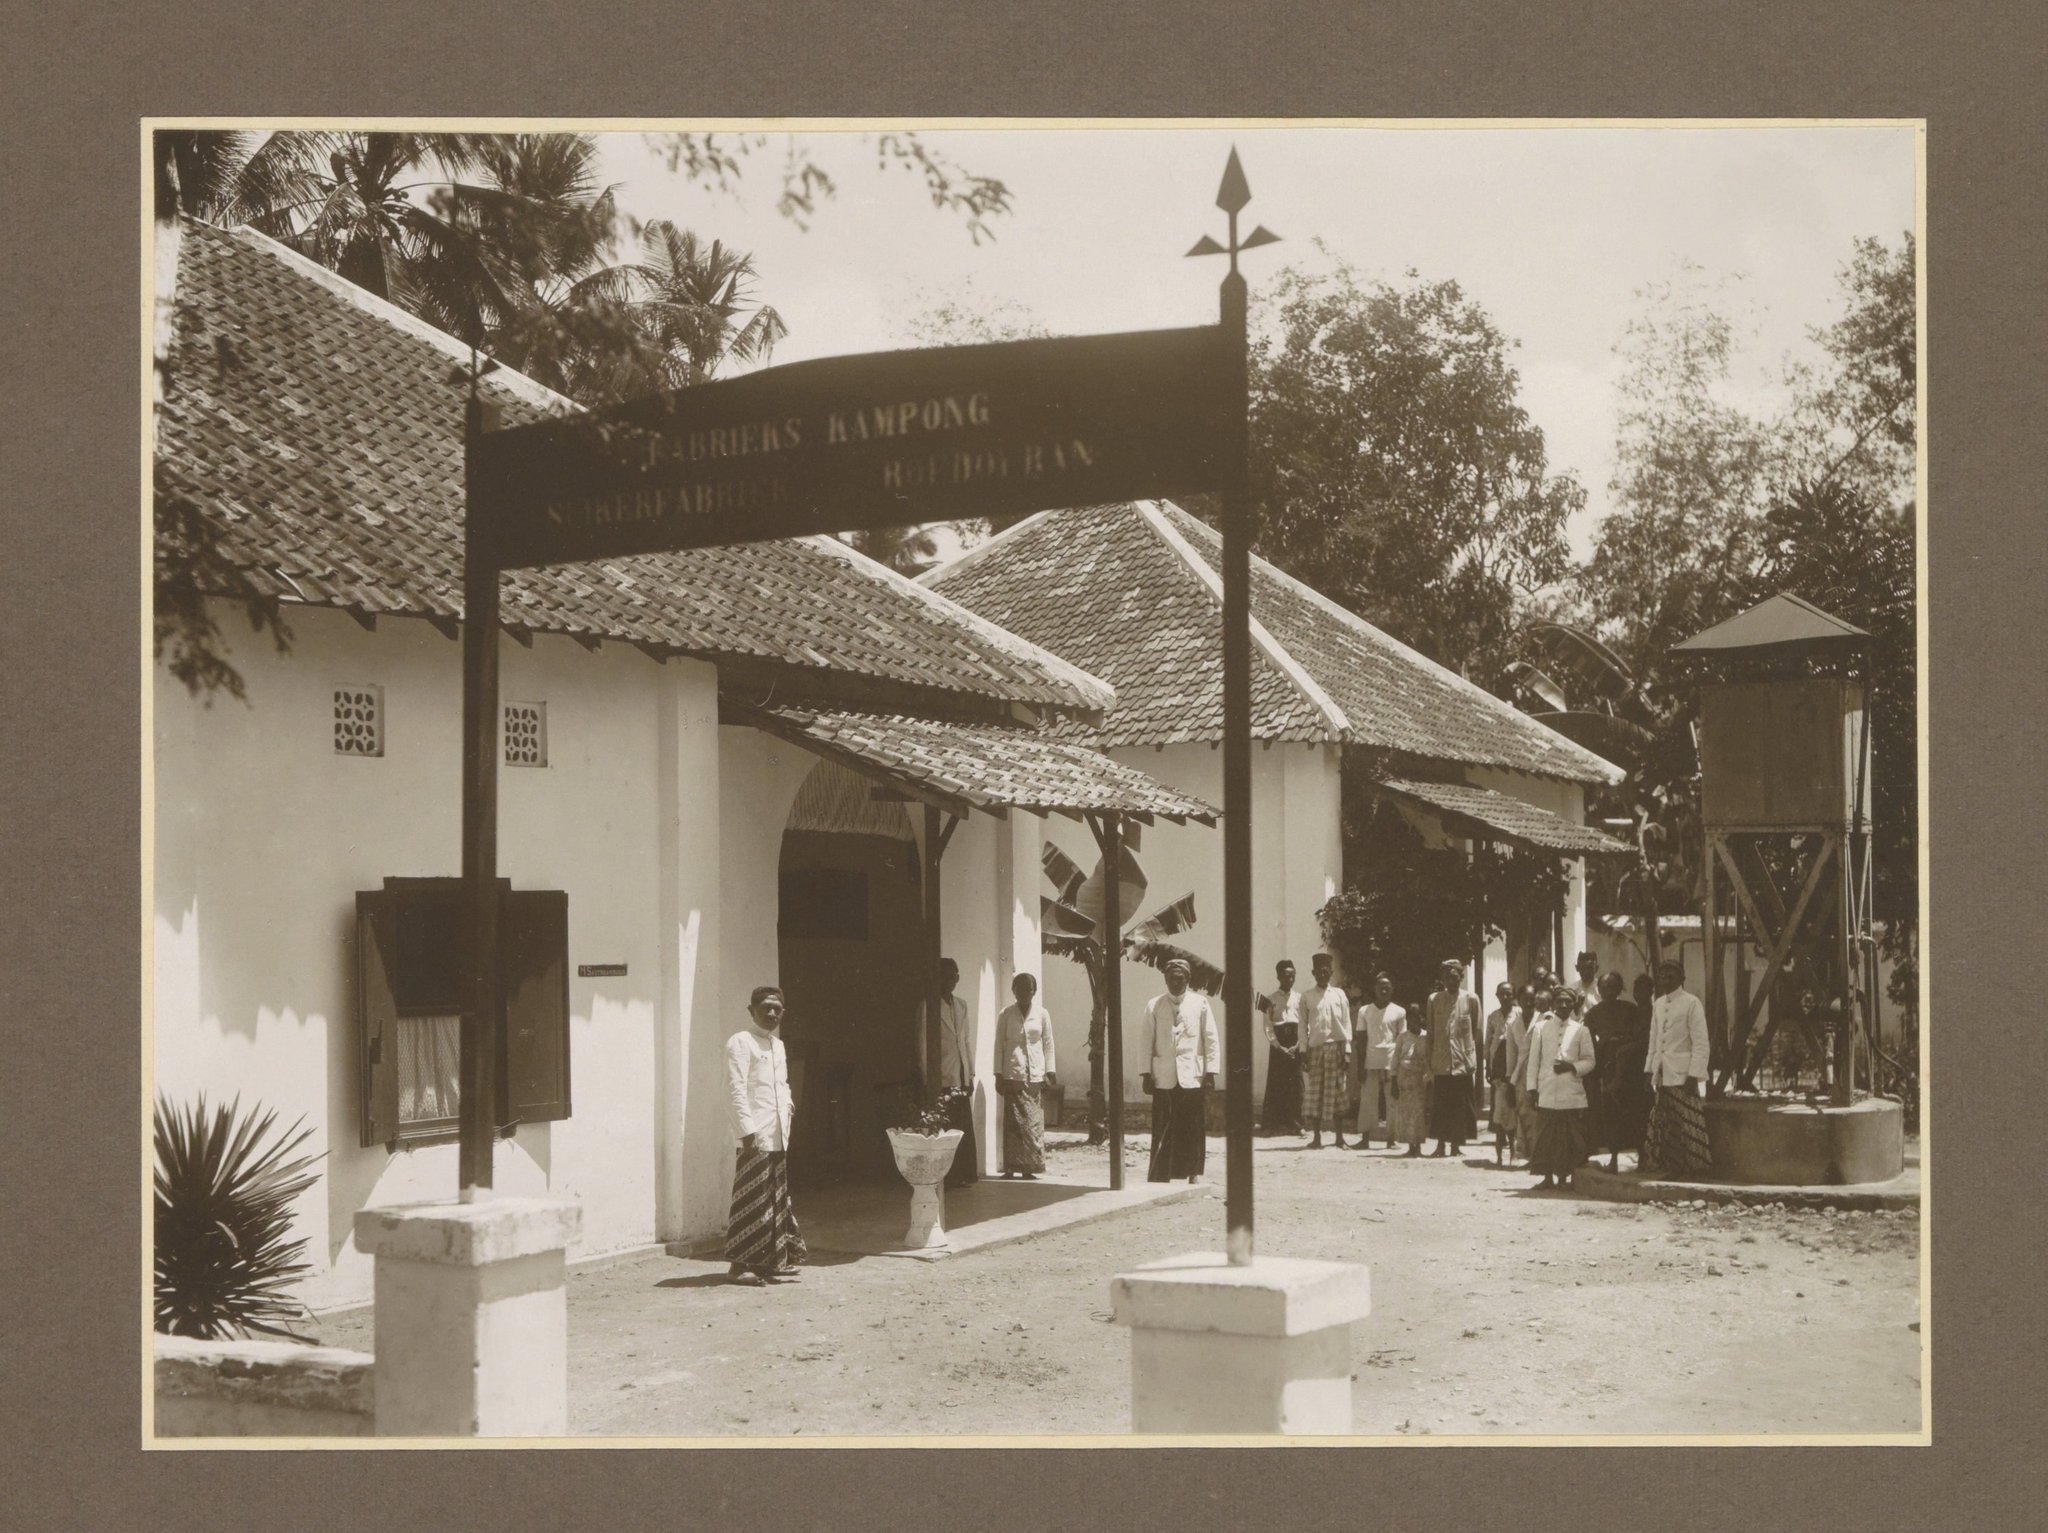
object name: photograph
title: Sf. Boedoeran Fabriekskampong met bewoners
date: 1925-1930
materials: cardboard, paper, photographic support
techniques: gelatin silver print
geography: sidoarjo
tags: plantation, village, gate, entrance, plants and herbs: sugarcane, sugar, dutch east indies, the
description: Onderdeel van Fotoalbum met opnames van vier suikerfabrieken op Java.